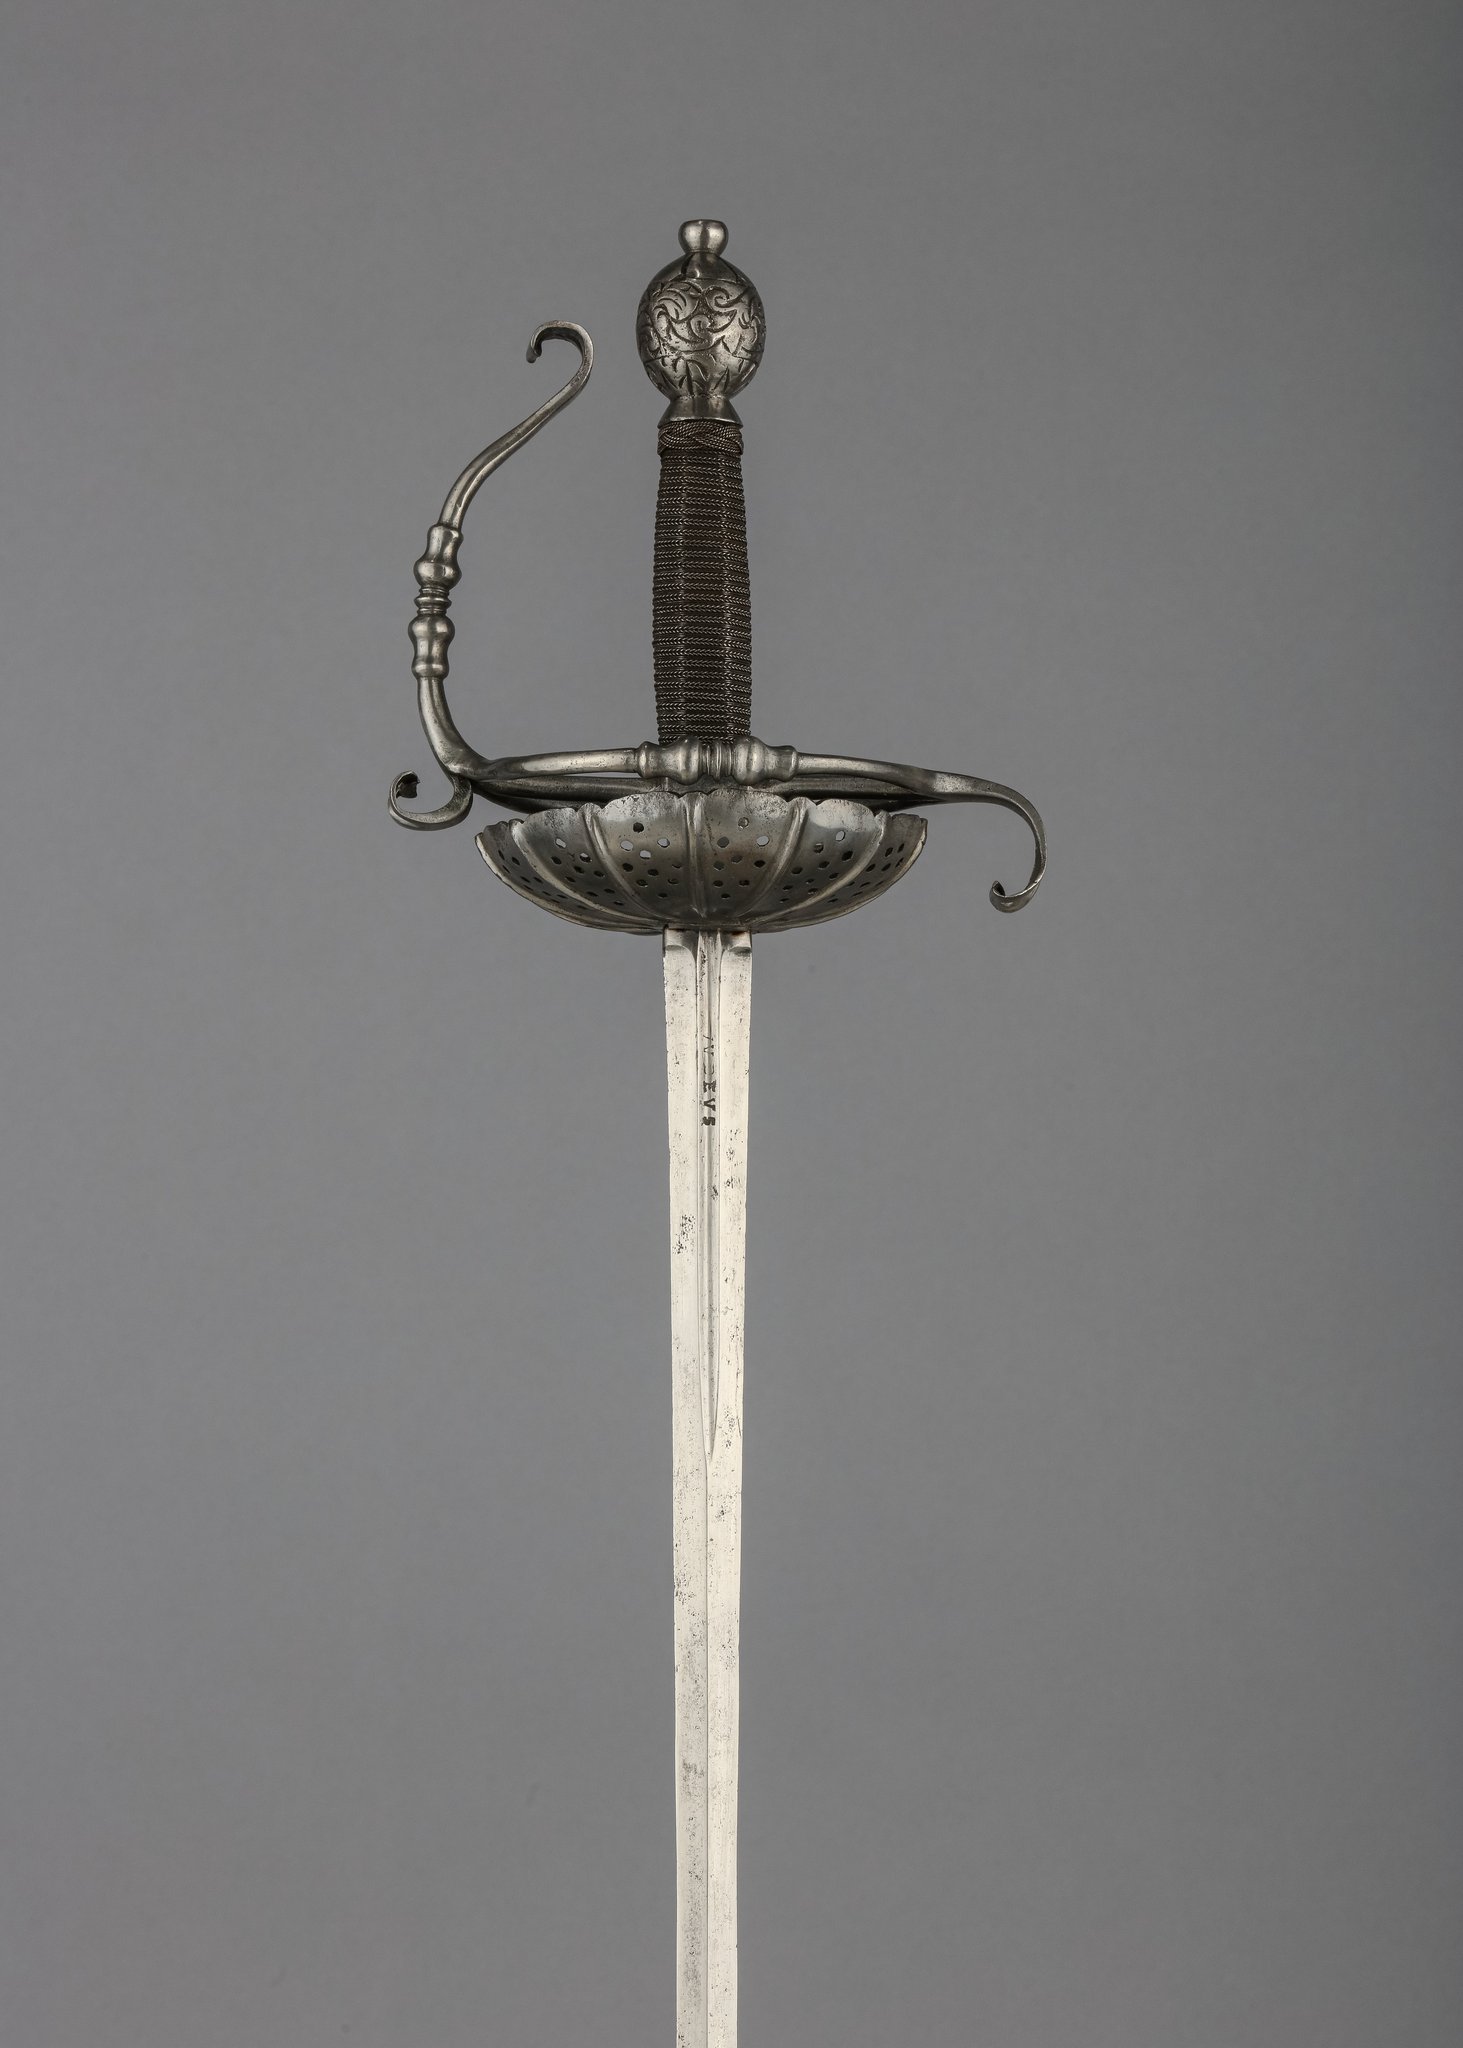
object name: smallsword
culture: italian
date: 1650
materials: steel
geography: italy